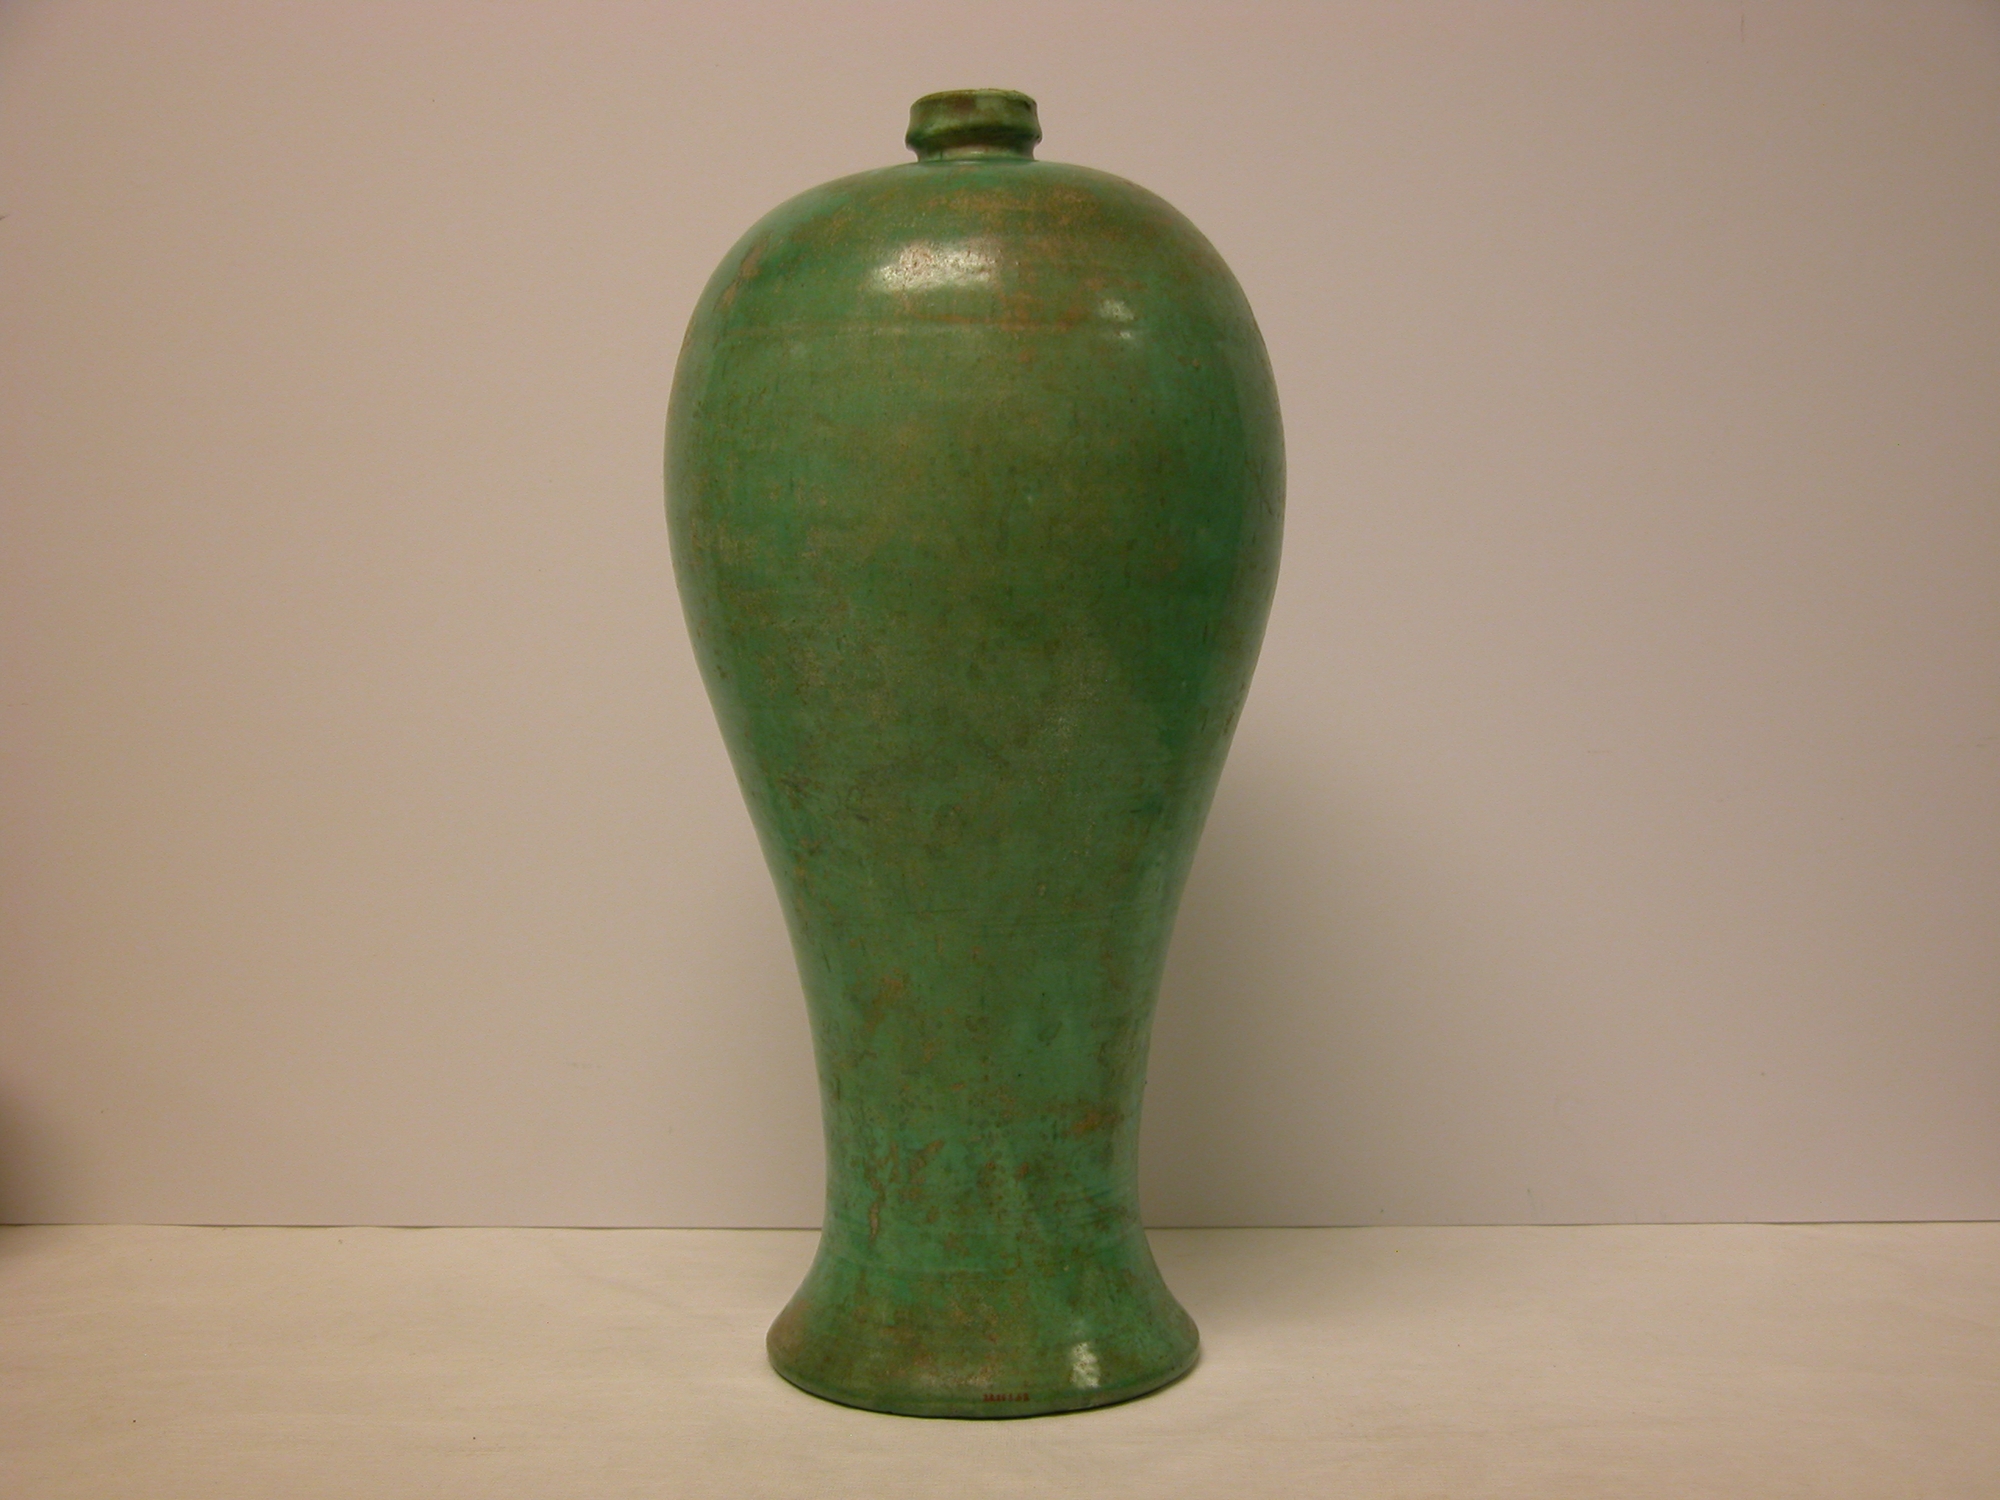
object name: vase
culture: chinese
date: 1368-1644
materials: glaze, stoneware